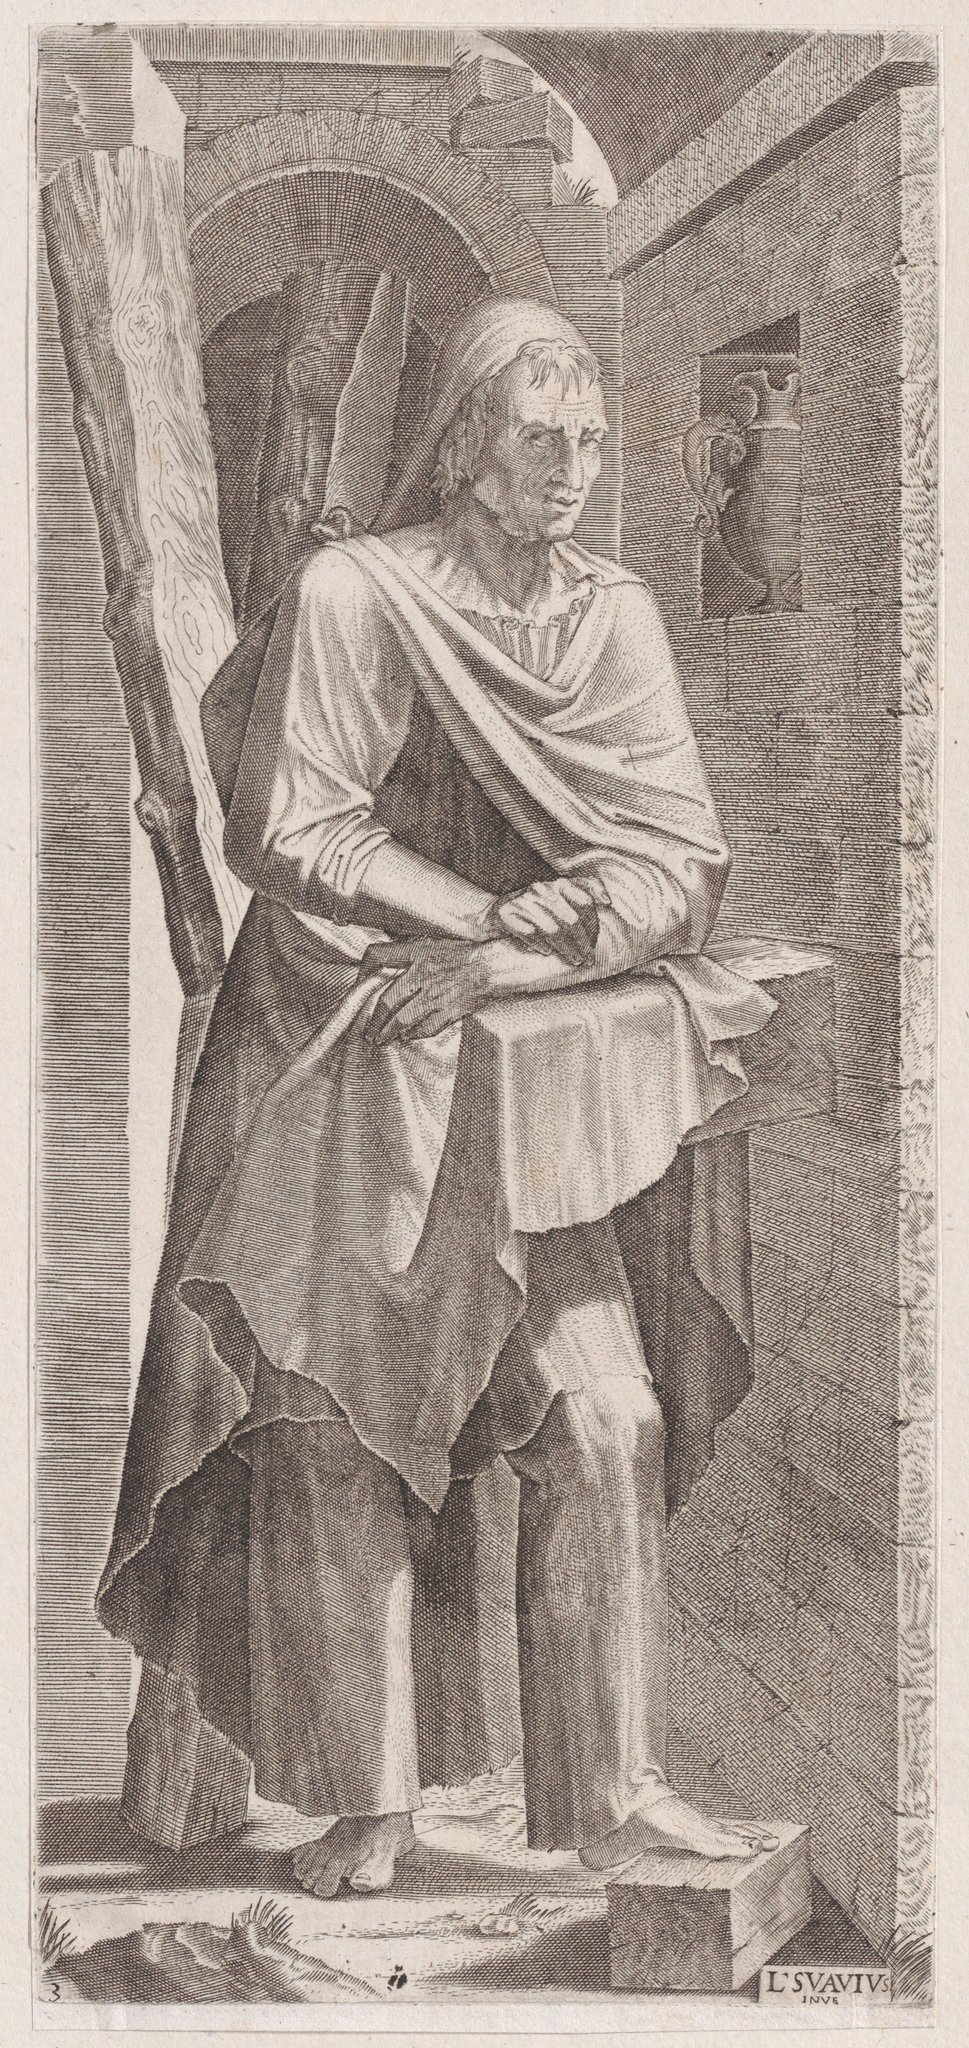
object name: print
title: St. Andrew, from "Christ, the Twelve Apostles and St. Paul"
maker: lambert suavius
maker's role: artist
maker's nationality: netherlandish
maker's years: 1510-1576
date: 1525-1576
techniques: engraving